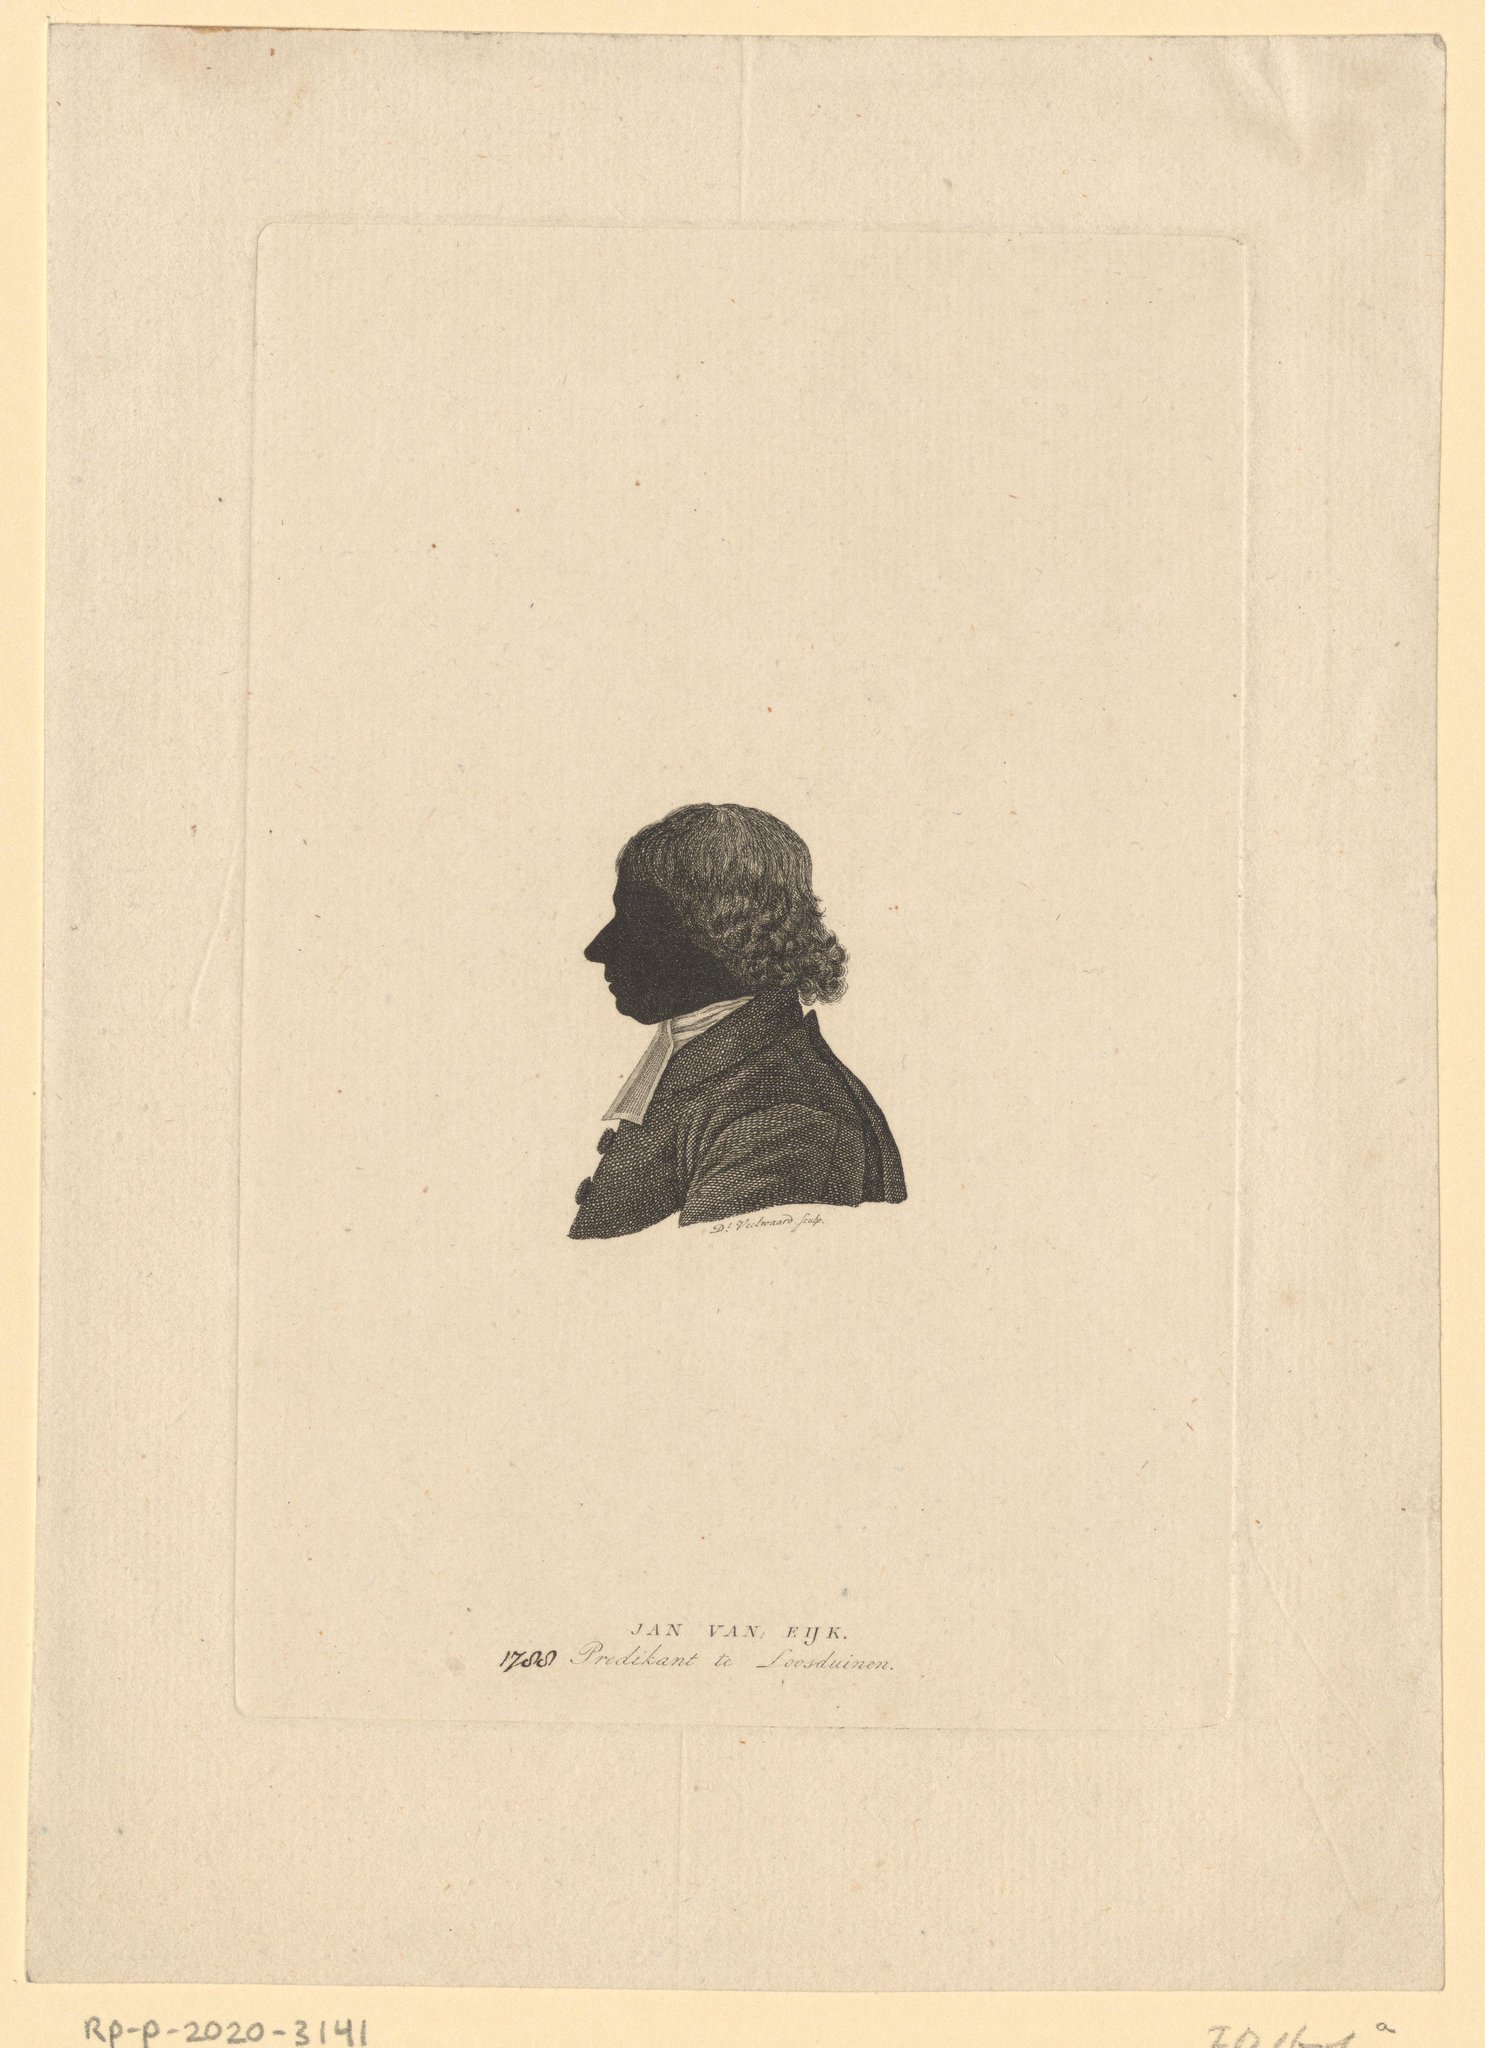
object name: print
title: Silhouetportret van Jan van Eijk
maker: daniël veelwaard (i)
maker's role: print maker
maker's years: 1766-1851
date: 1788-1822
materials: paper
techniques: etching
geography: amsterdam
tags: historical persons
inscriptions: inscription: ‘1788’